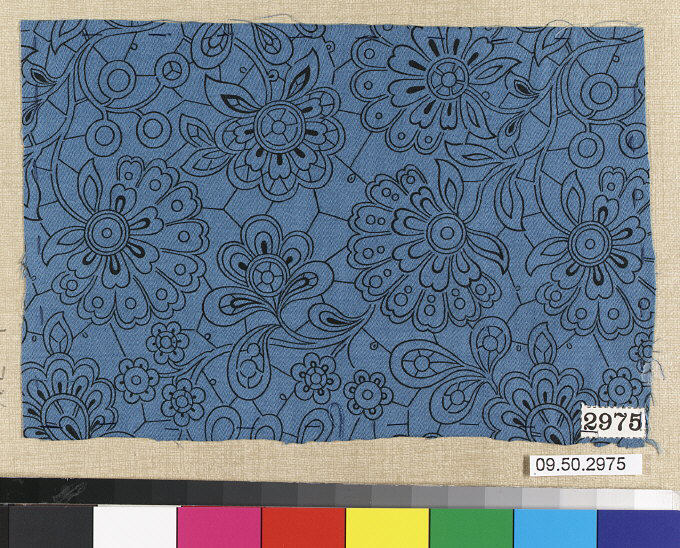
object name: piece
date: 1801-1900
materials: cotton